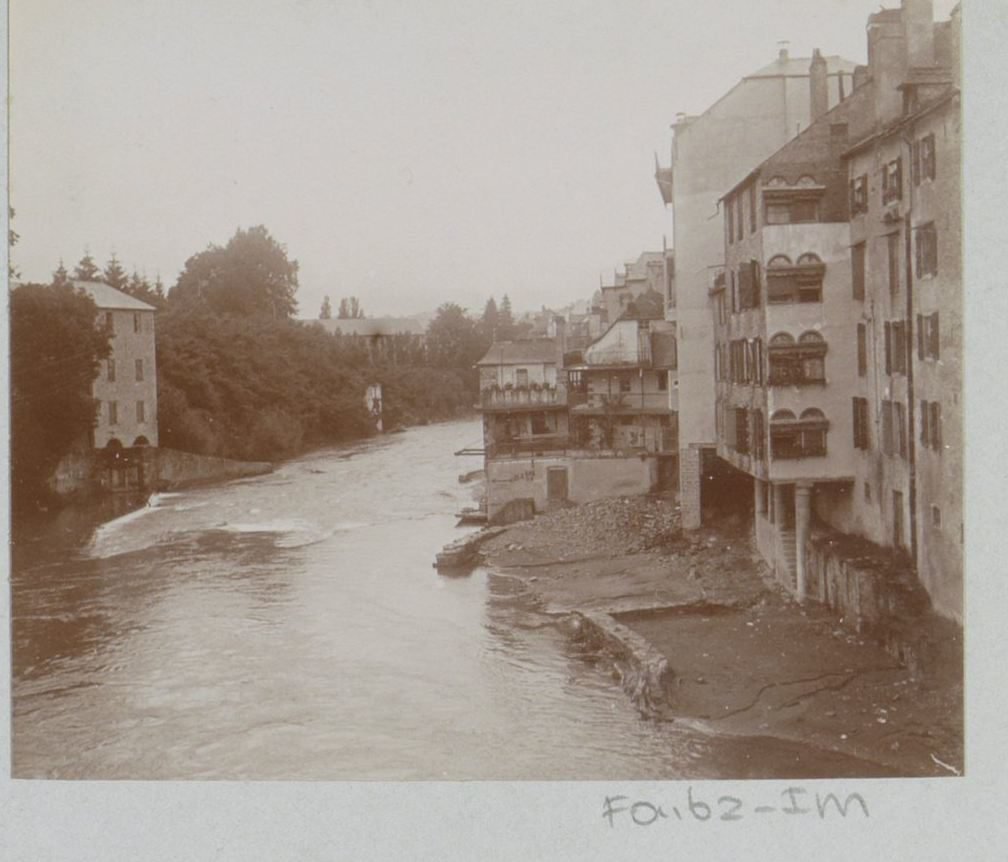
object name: photograph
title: Huizen op een rivieroever, vermoedelijk in Frankrijk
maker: Anonymous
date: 1905-1910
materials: paper, photographic support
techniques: gelatin silver print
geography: france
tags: prospect of village, silhouette of village, river bank, river (+ landscape with figures, staffage), france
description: Onderdeel van Fotoalbum van een Franse amateurfotograaf met bezienswaardigheden in Frankrijk, Zwitserland en Italië.